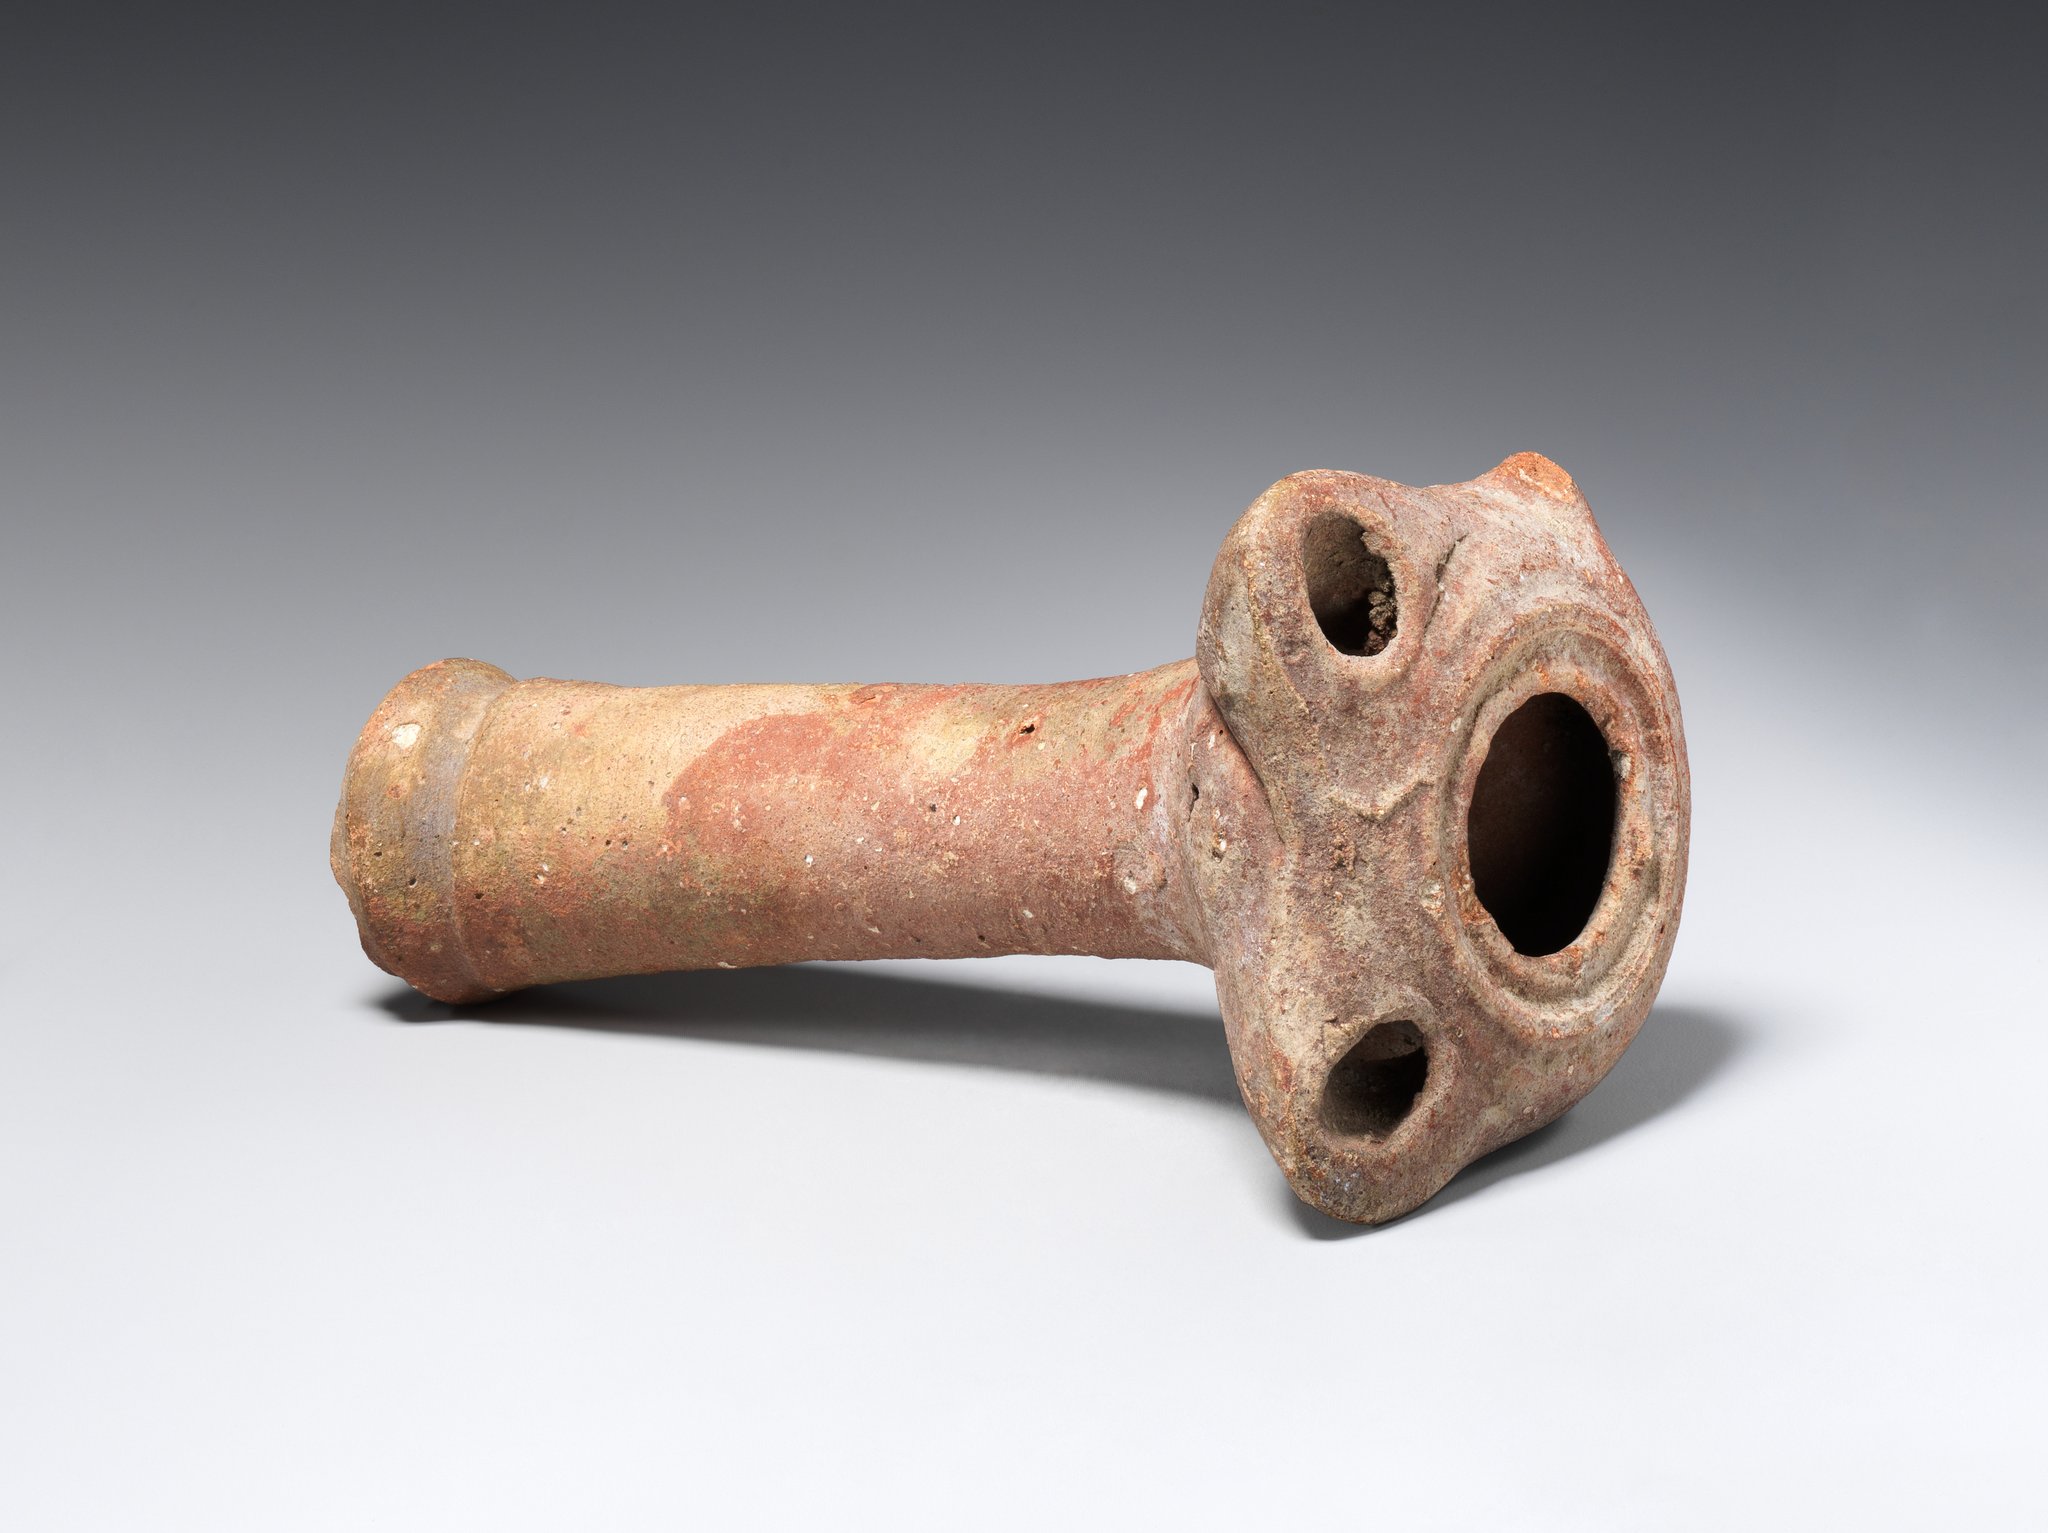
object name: lamp key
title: Lamp (Key ?)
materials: pottery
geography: egypt